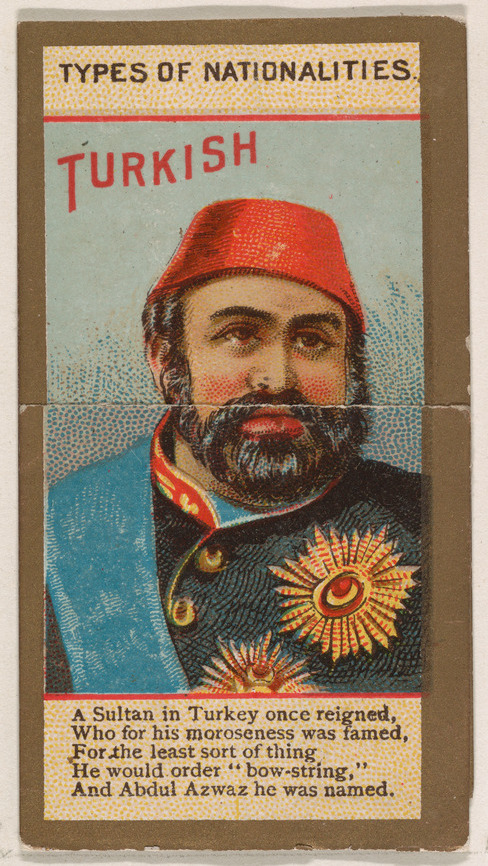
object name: print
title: Turkish, from Types of Nationalities (N240) issued by Kinney Bros.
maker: kinney brothers tobacco company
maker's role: publisher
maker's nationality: american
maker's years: 1869-2011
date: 1890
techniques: color lithograph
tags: men